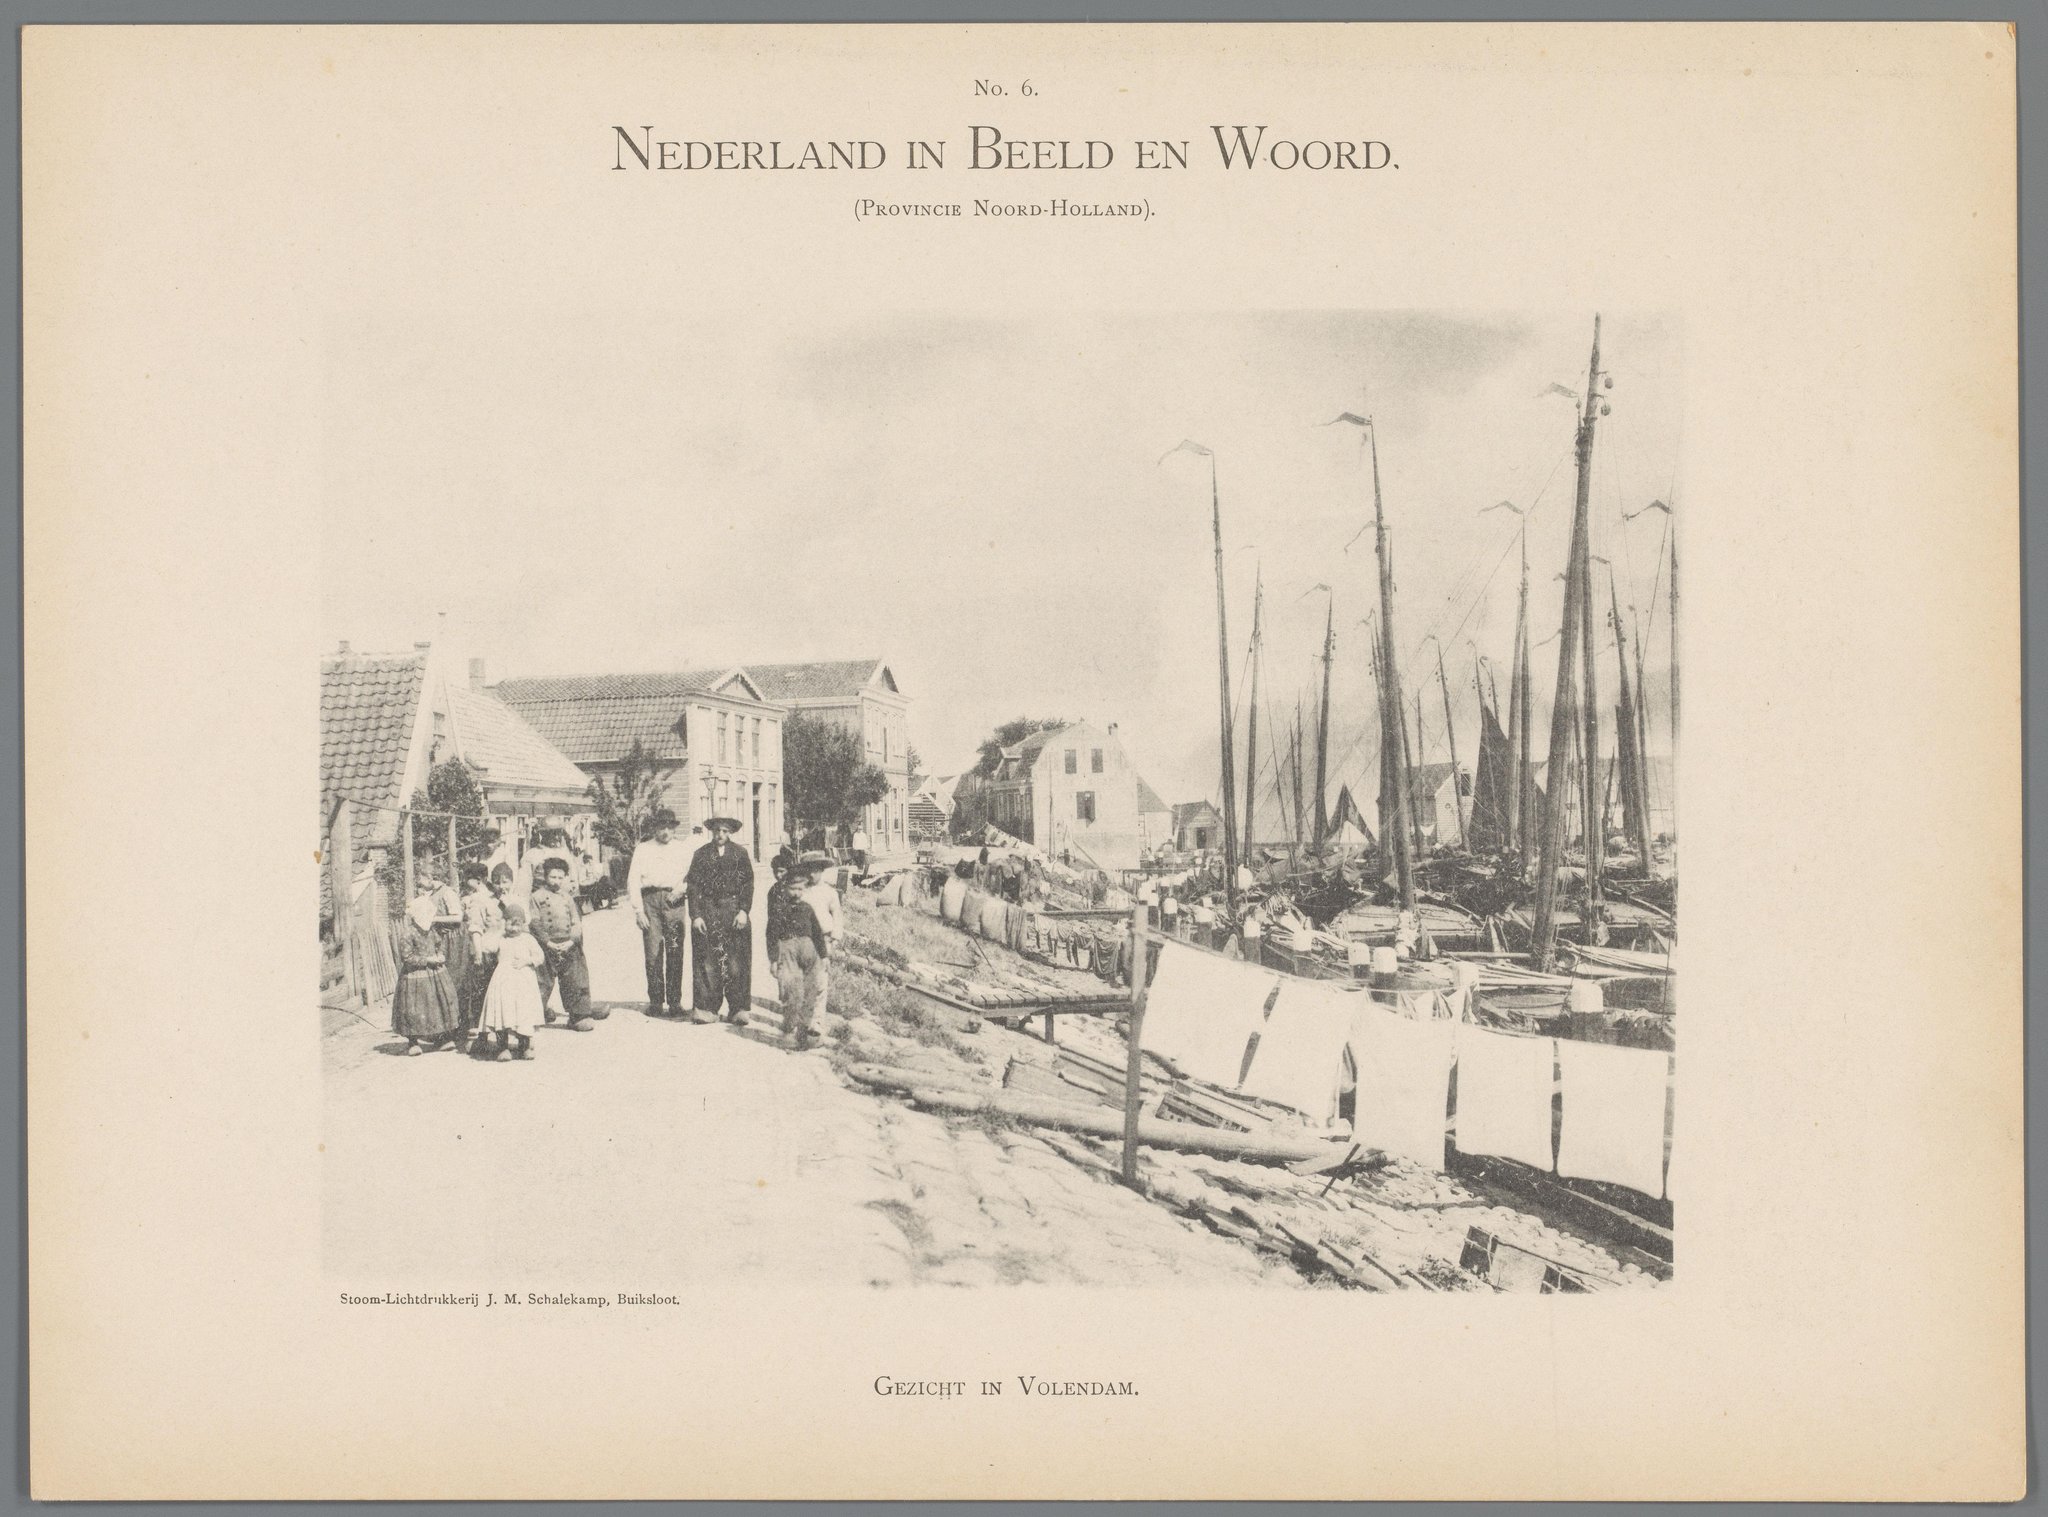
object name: photomechanical print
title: Gezicht in Volendam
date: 1890-1895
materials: cardboard, paper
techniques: photograph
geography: buiksloot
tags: harbour, hanging the wash to dry, quay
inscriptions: number: ‘No. 6.’